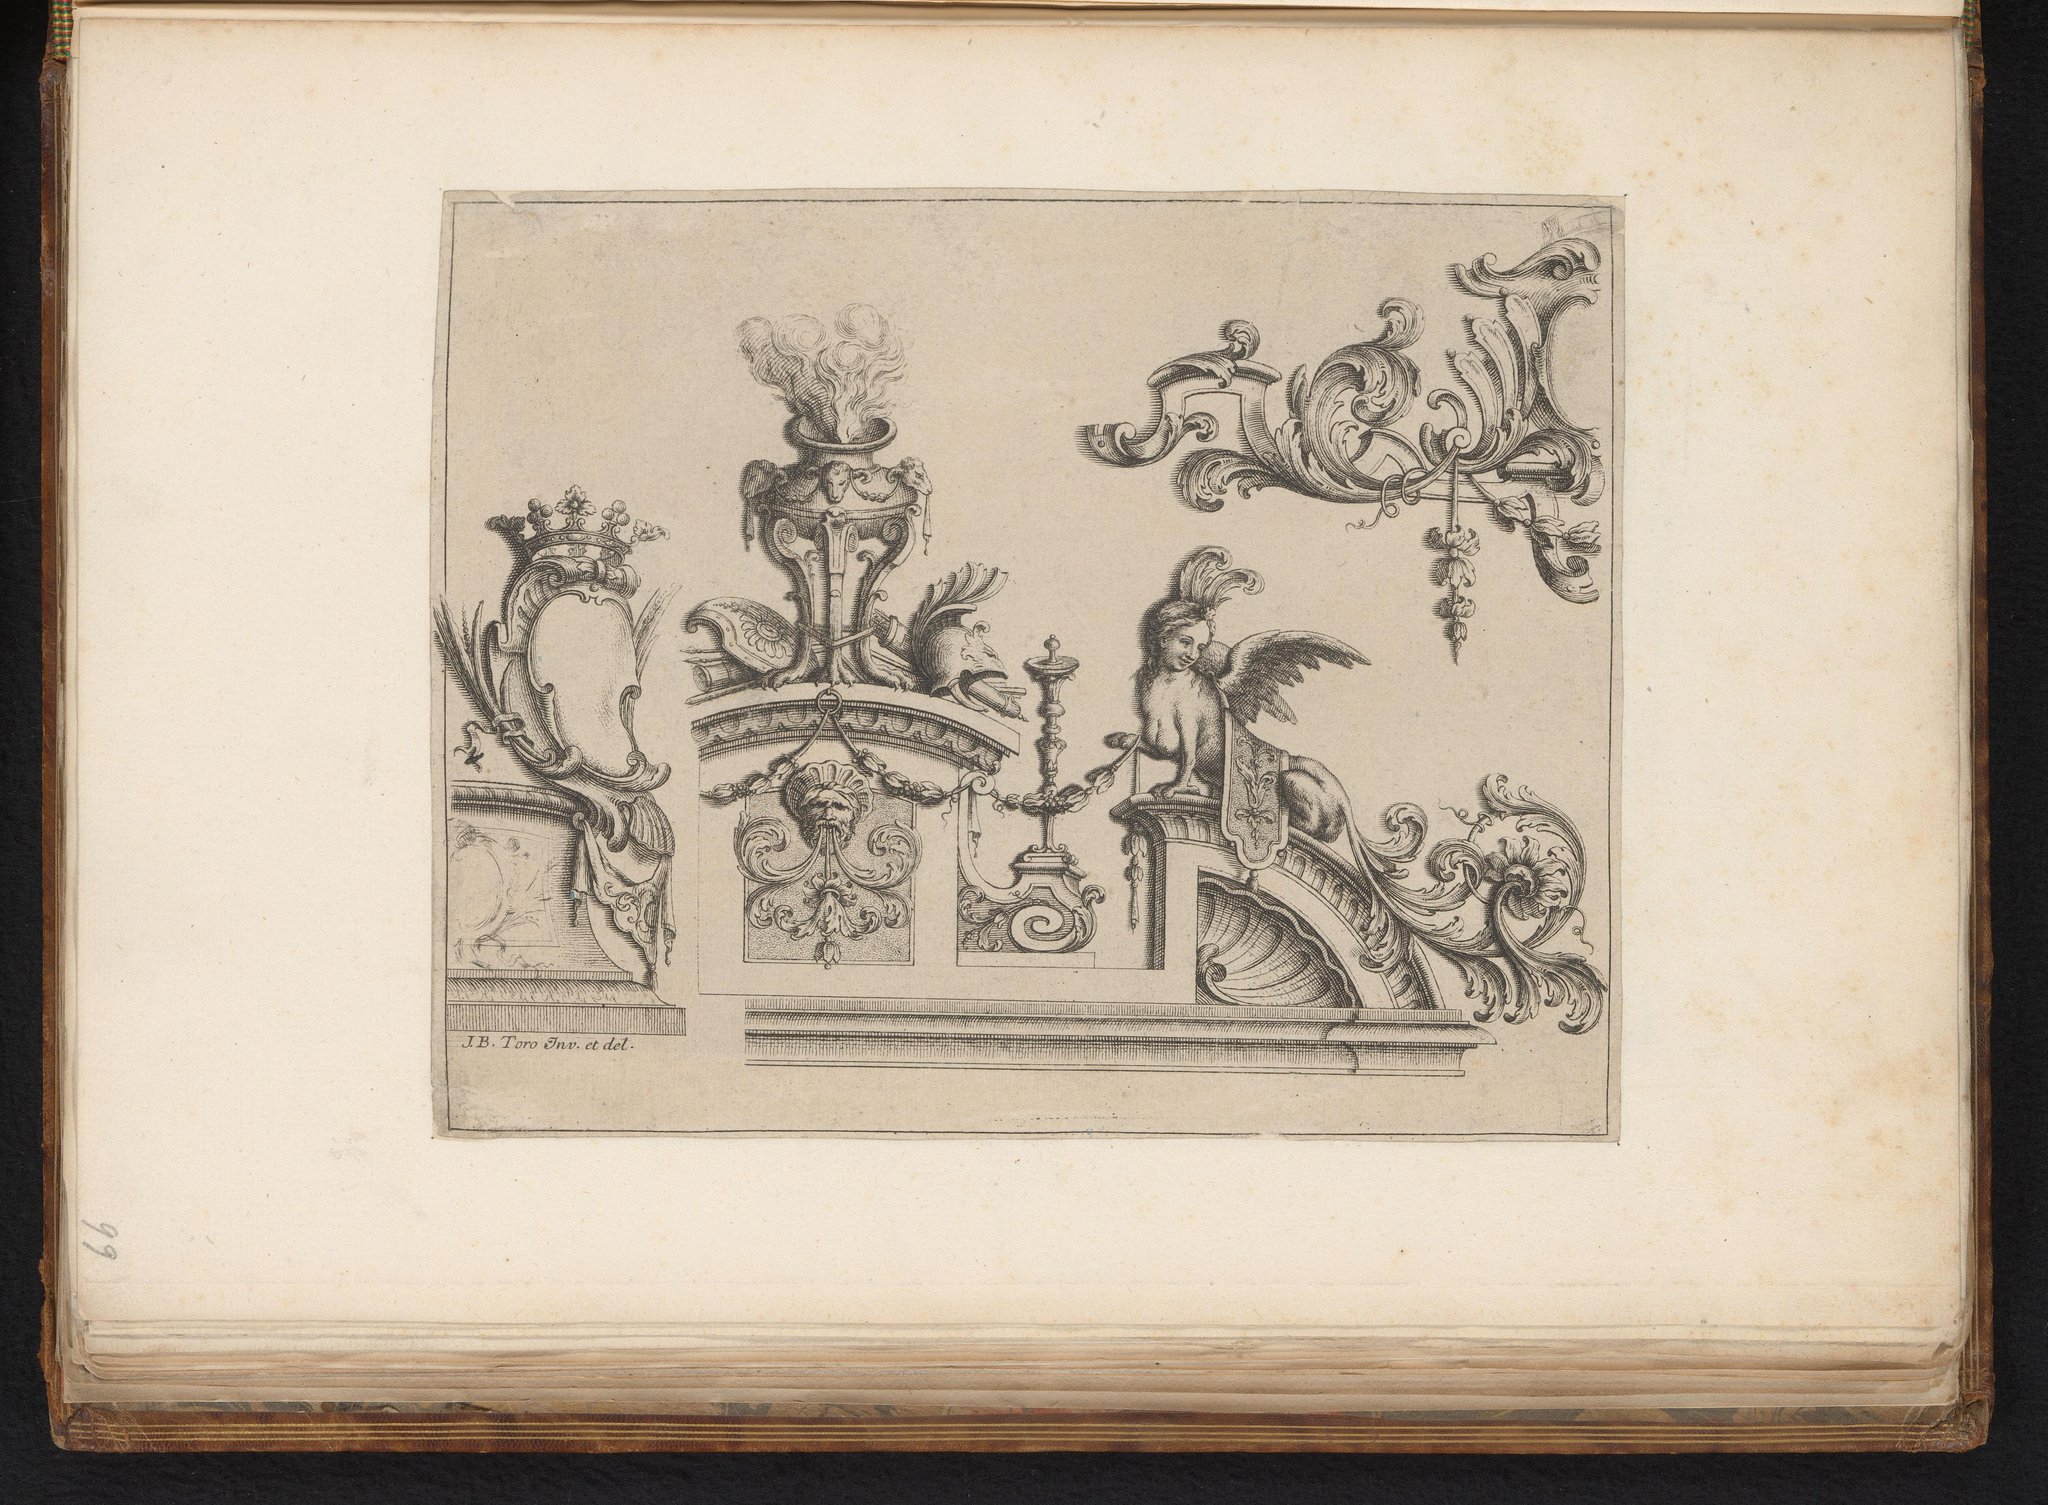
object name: ornament print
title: Nouvelle Maniere D'Ornements Faciles [...]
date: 1682-1739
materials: paper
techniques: etching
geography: paris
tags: monsters ~ predatory animals (sphinx, 'manticora') - aa - female human figure, acanthus ~ ornament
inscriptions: collector's mark: Lugt 2760, collector's mark: Lugt 2228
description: Prent maakt deel uit van een serie van zeven prenten.